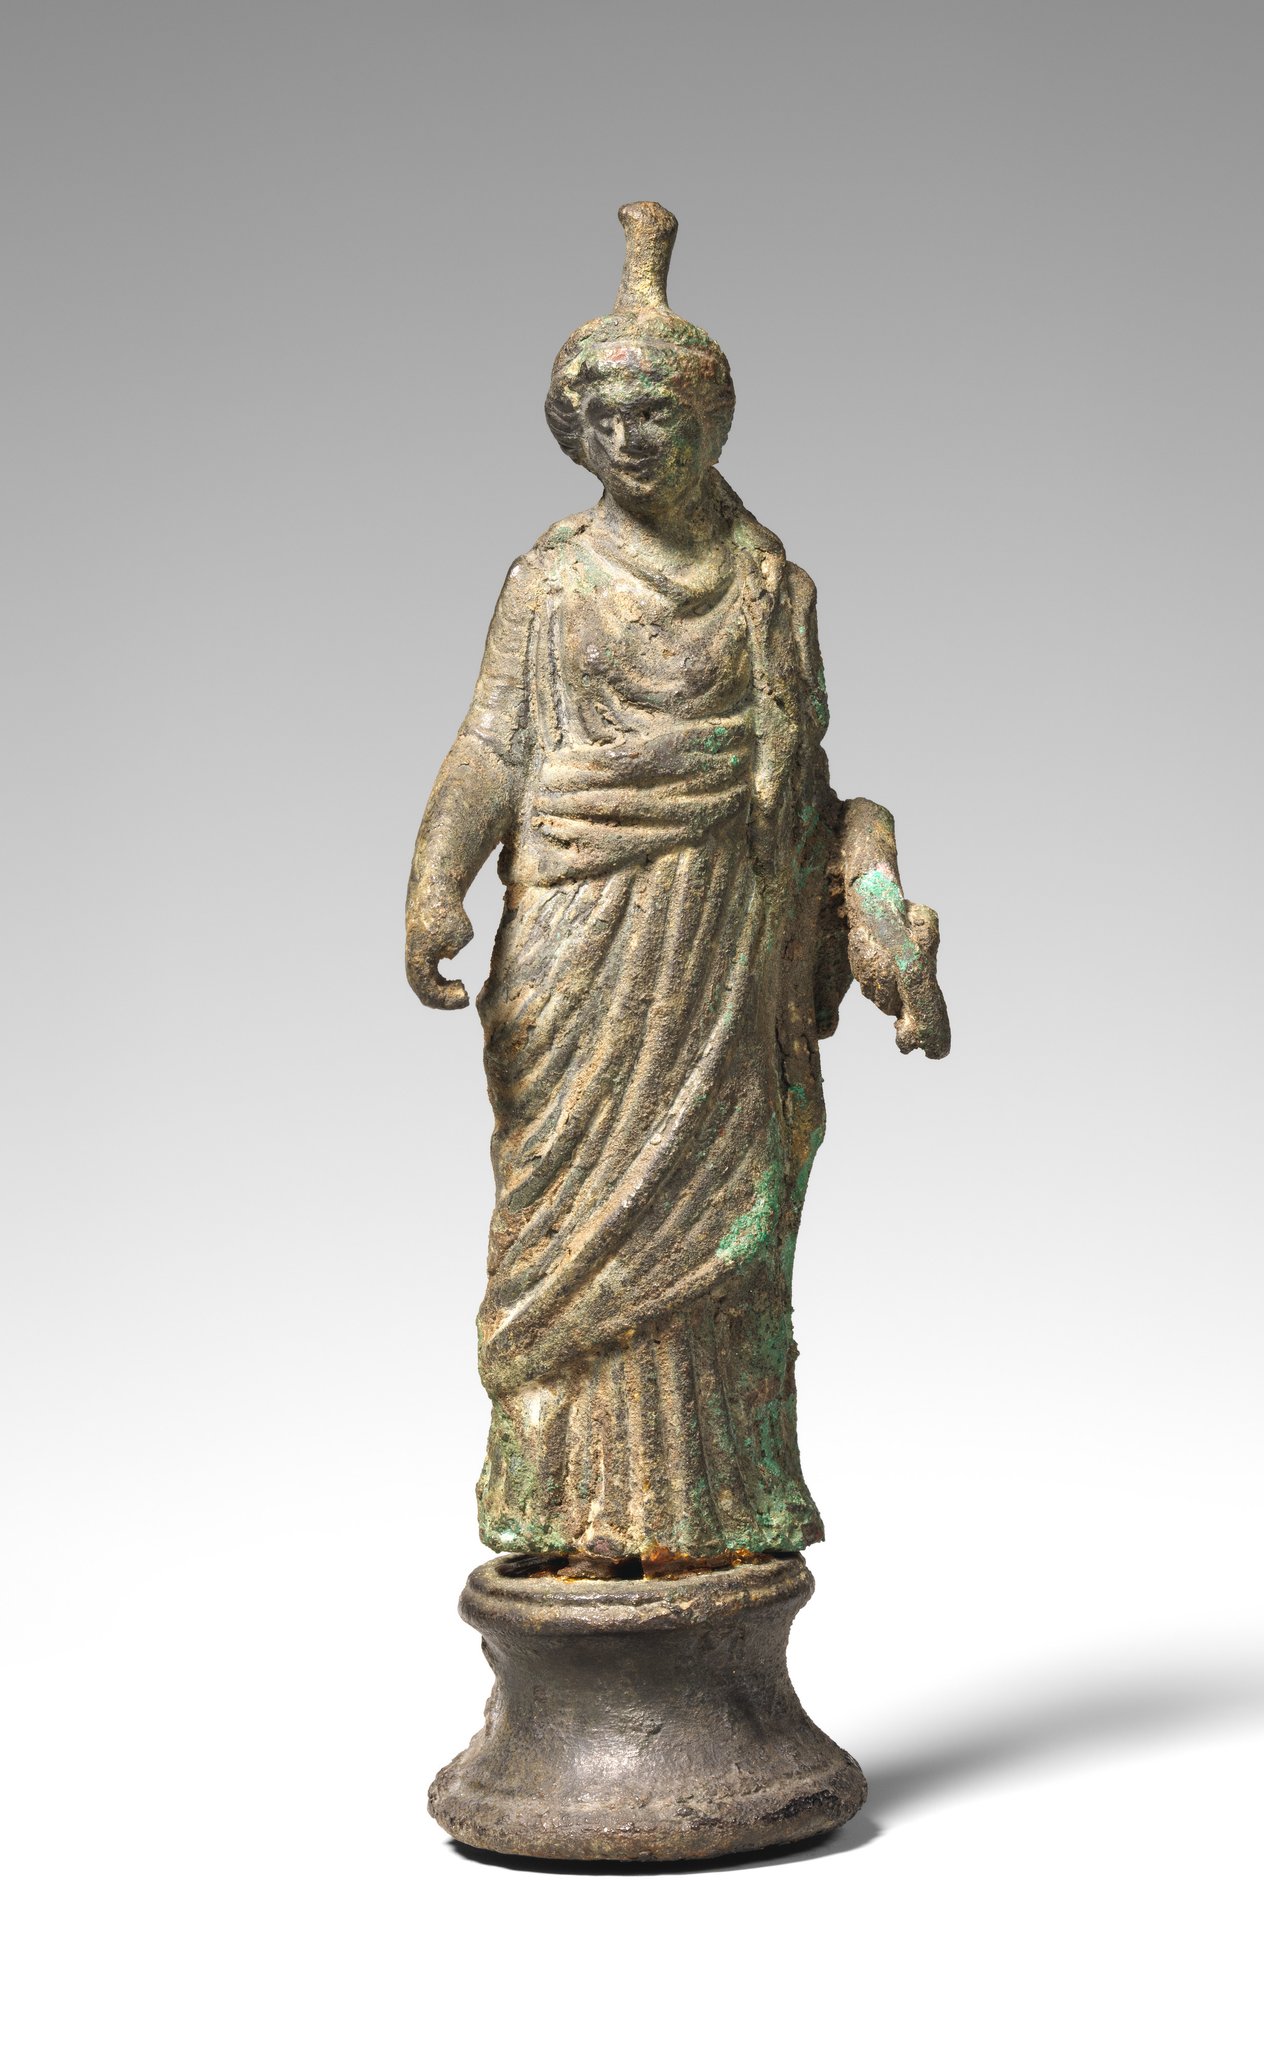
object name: statuette of fortuna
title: Bronze statuette of Tyche/Fortuna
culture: greek or roman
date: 1-100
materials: bronze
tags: goddess